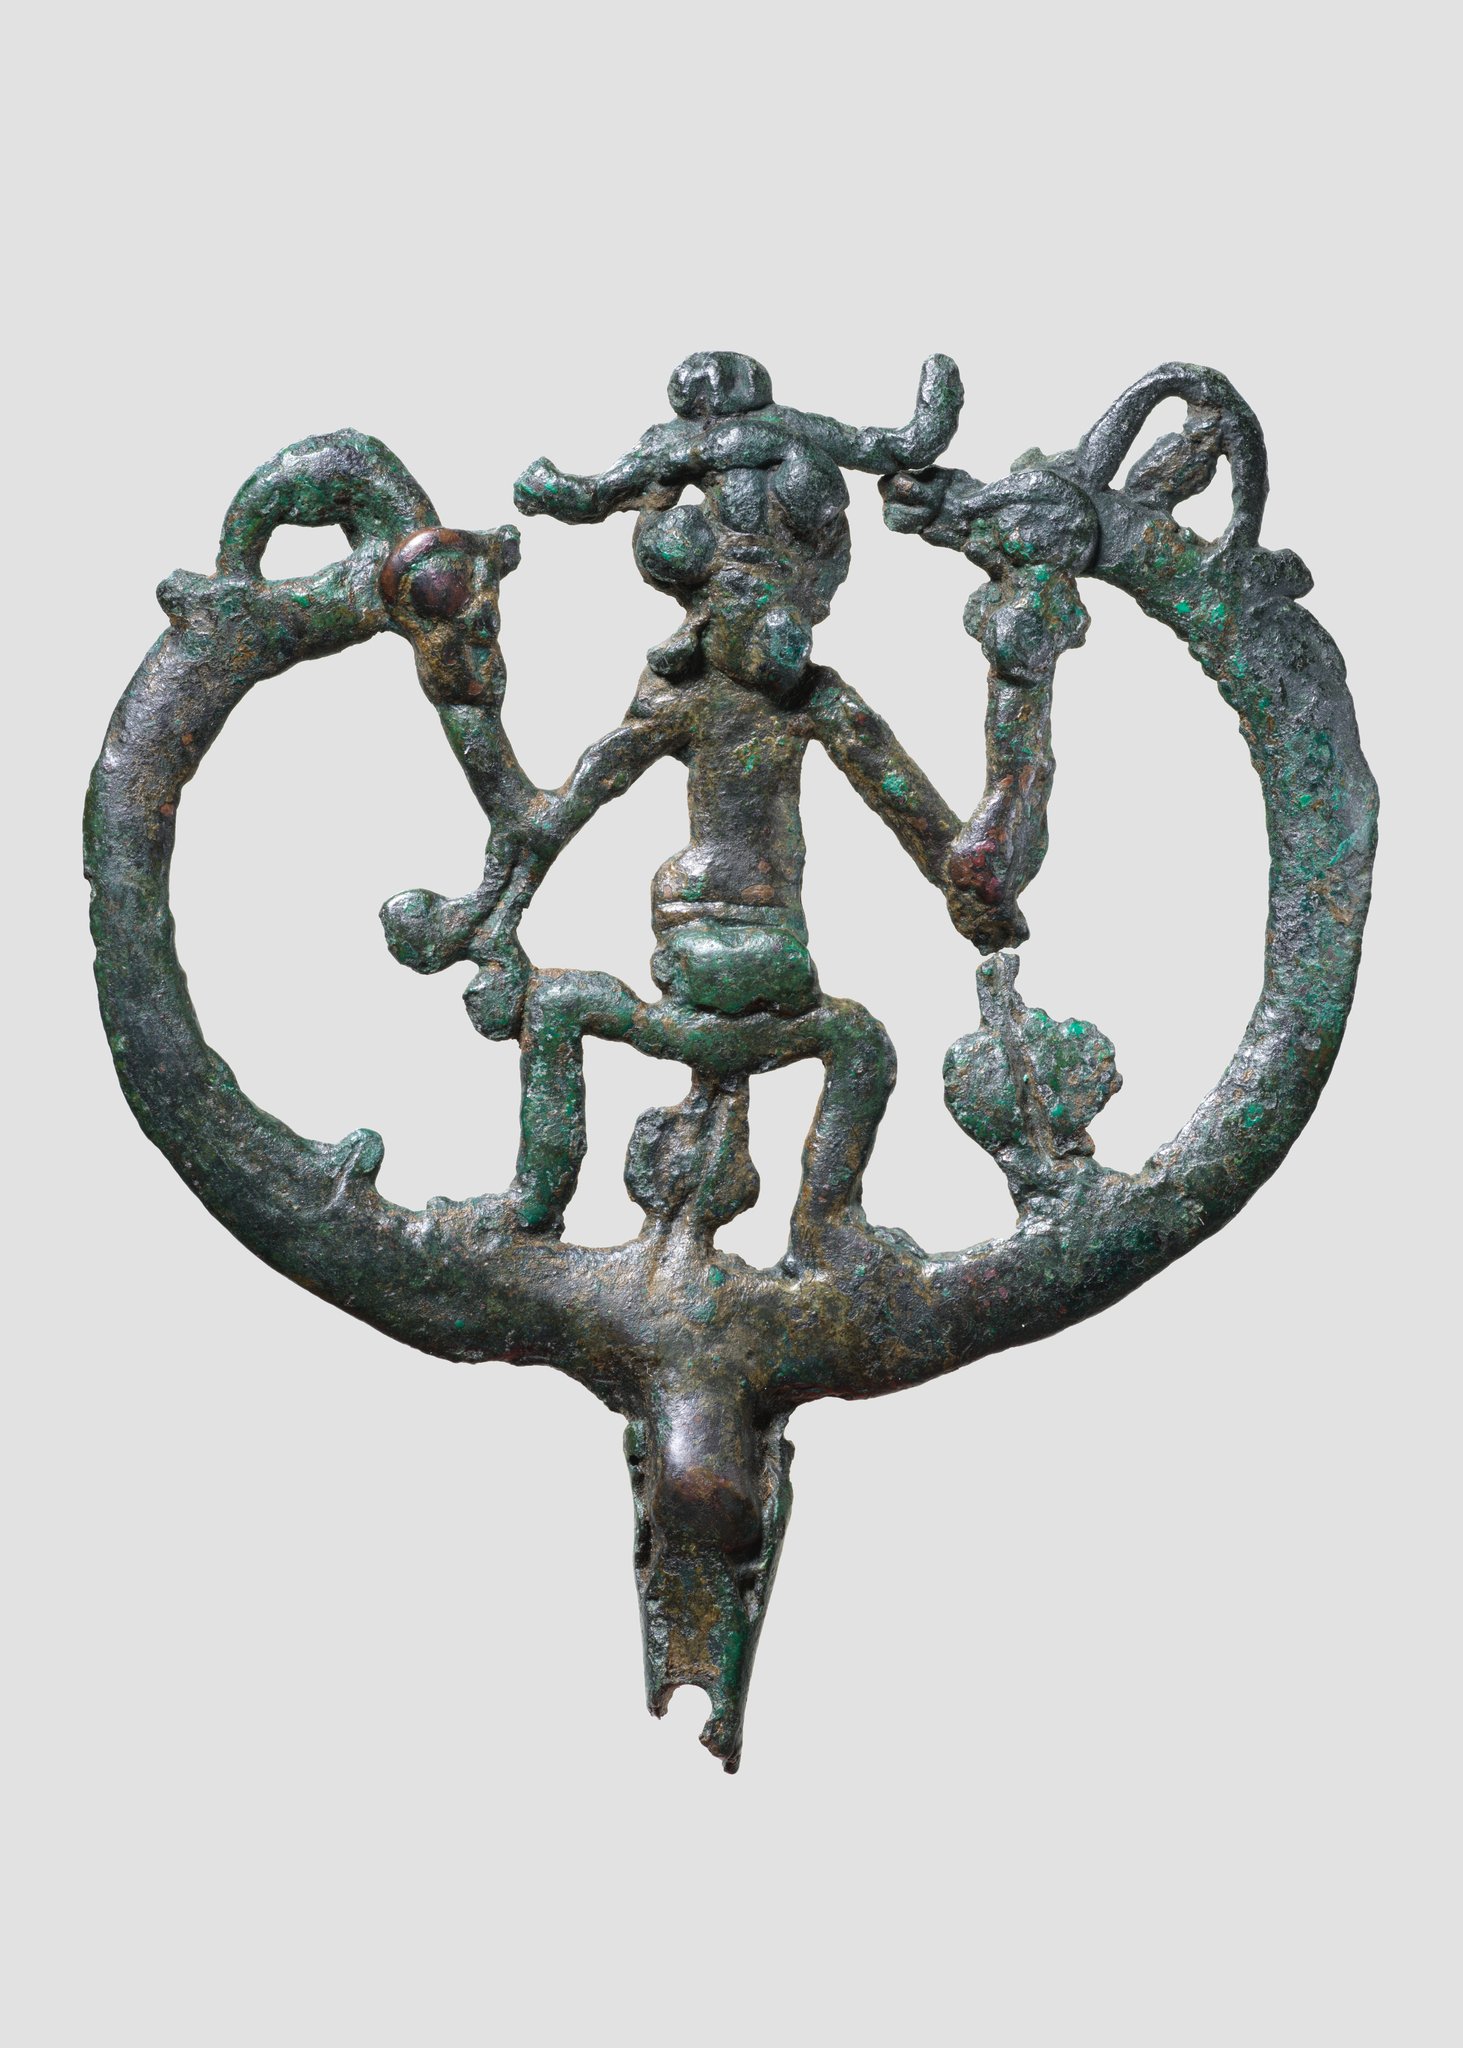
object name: pin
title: Openwork pin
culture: iranian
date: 800-601 BCE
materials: bronze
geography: iran, probably from luristan